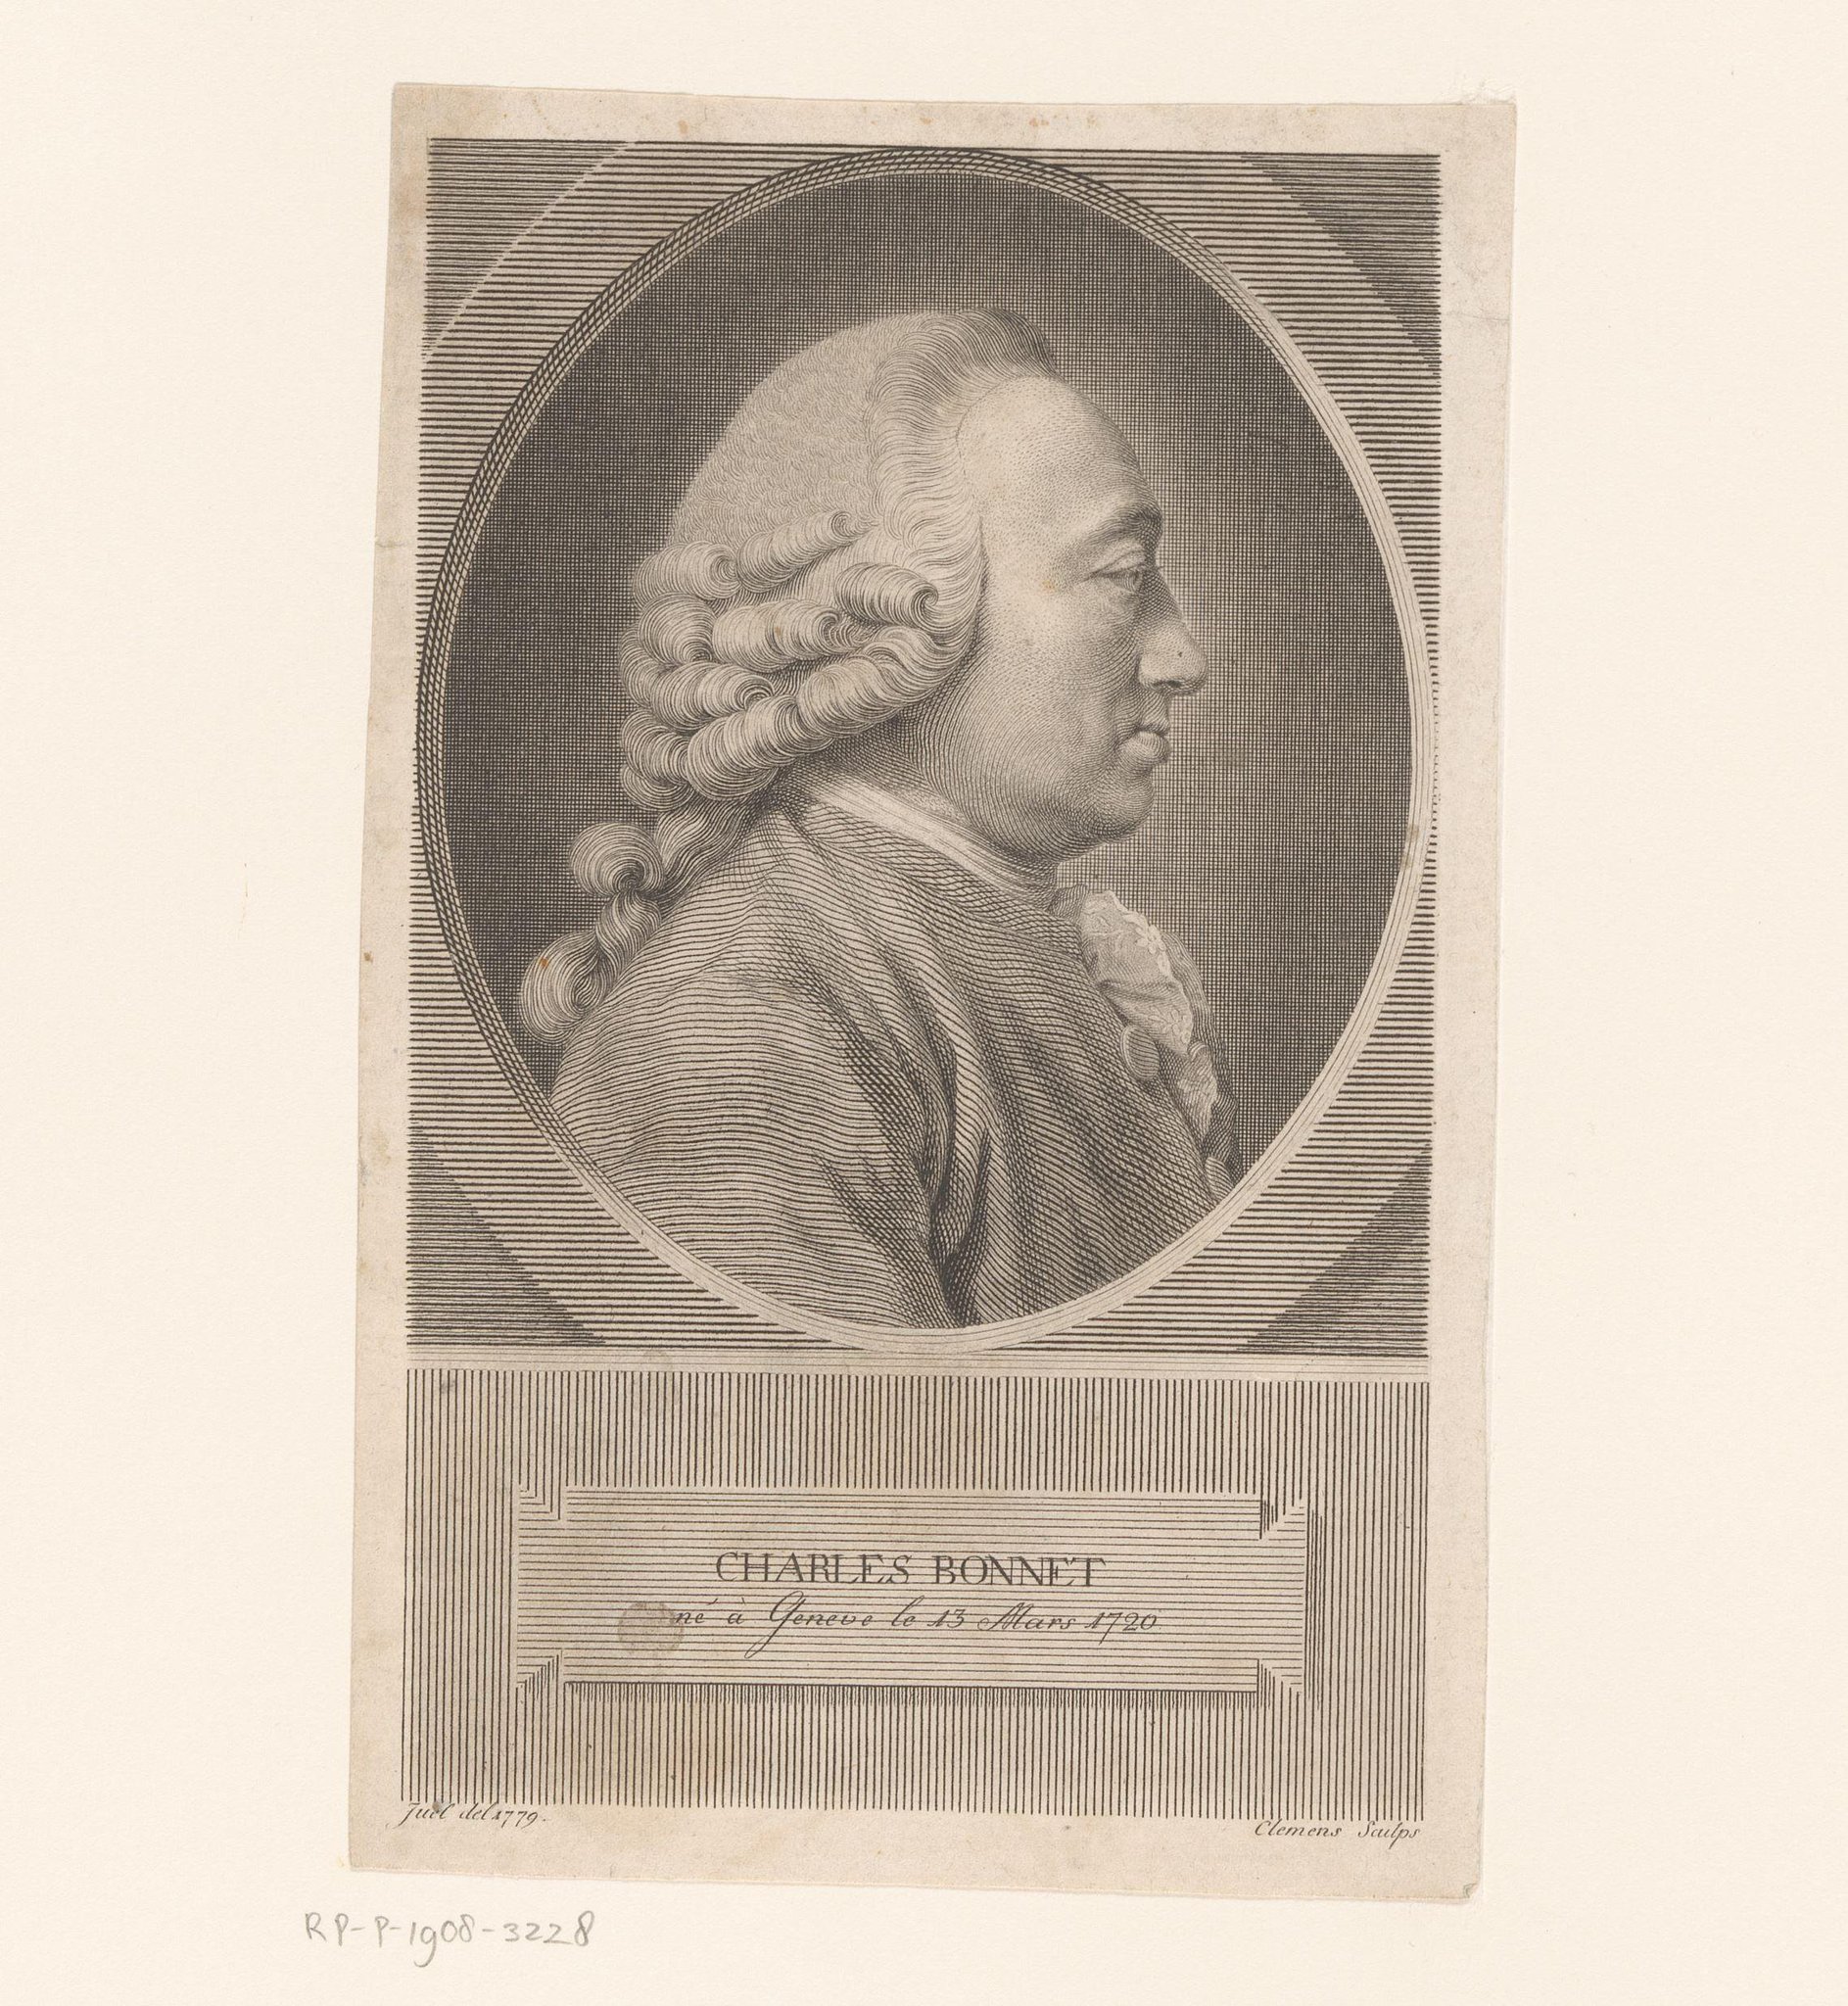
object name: print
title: Portret van Charles Bonnet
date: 1779-1793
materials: paper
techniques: engraving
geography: denmark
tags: historical persons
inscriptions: collector's mark: Lugt 2228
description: Portret van de wetenschapper Charles Bonnet, buste in ovaal, naar rechts.